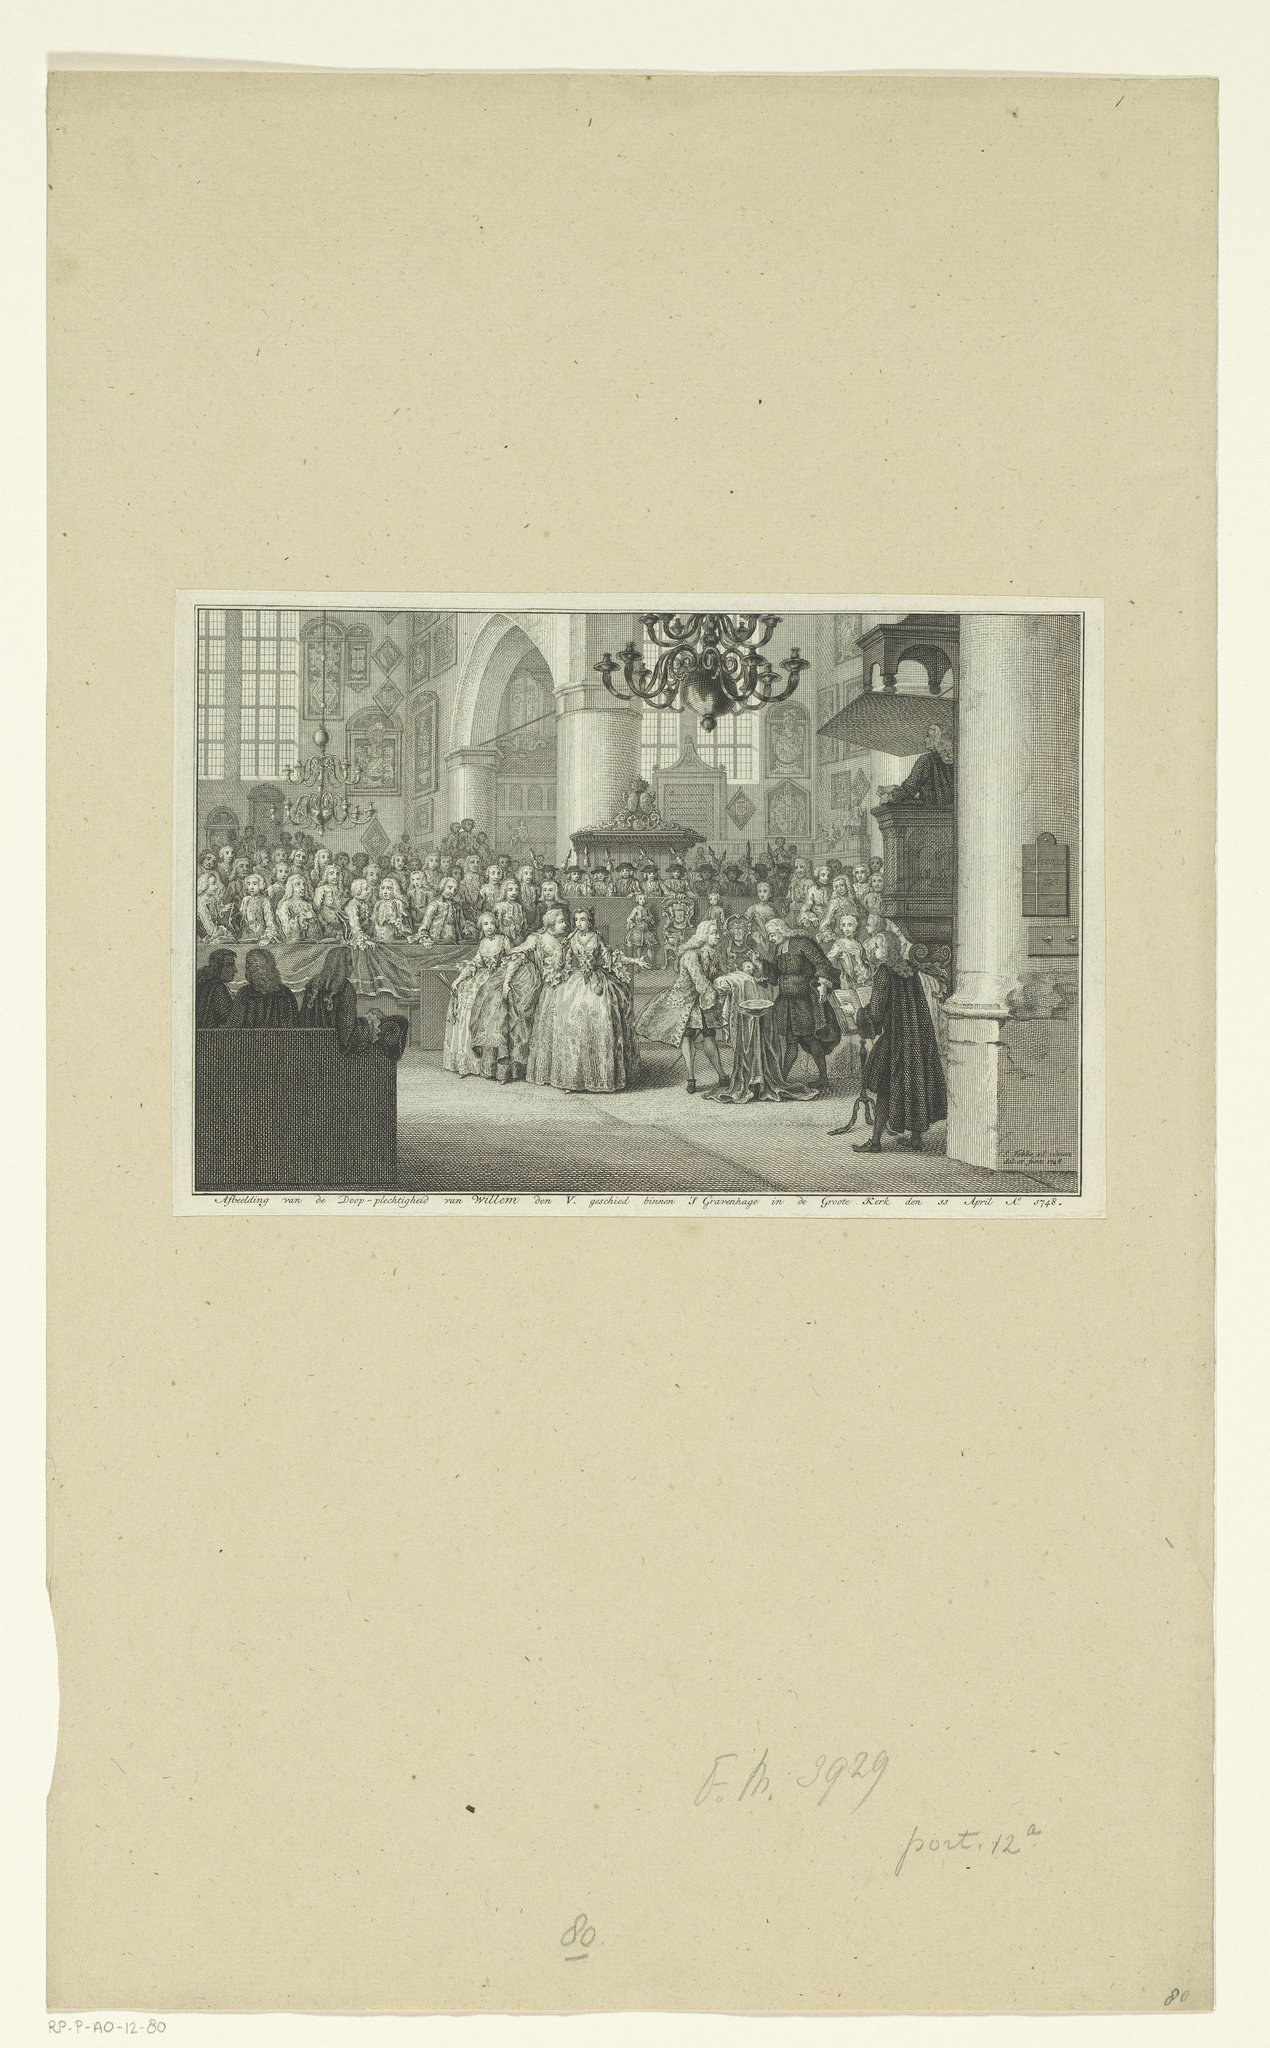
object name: print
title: Doop van prins Willem V, 1748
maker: simon fokke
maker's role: draughtsman, print maker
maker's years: 1712-1784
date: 1748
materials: paper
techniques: engraving, etching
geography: amsterdam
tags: the hague, william v (prince of orange), willem iv (prins van oranje-nassau), anna van hannover, baptism ~ protestant service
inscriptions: collector's mark: Lugt 195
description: Doopceremonie van prins Willem V in de Grote Kerk te Den Haag, 11 april 1748. Willem IV houdt het kind tijdens het dopen vast, links kijkt de prinses met hofdames toe. Kerkinterieur met vele gasten.